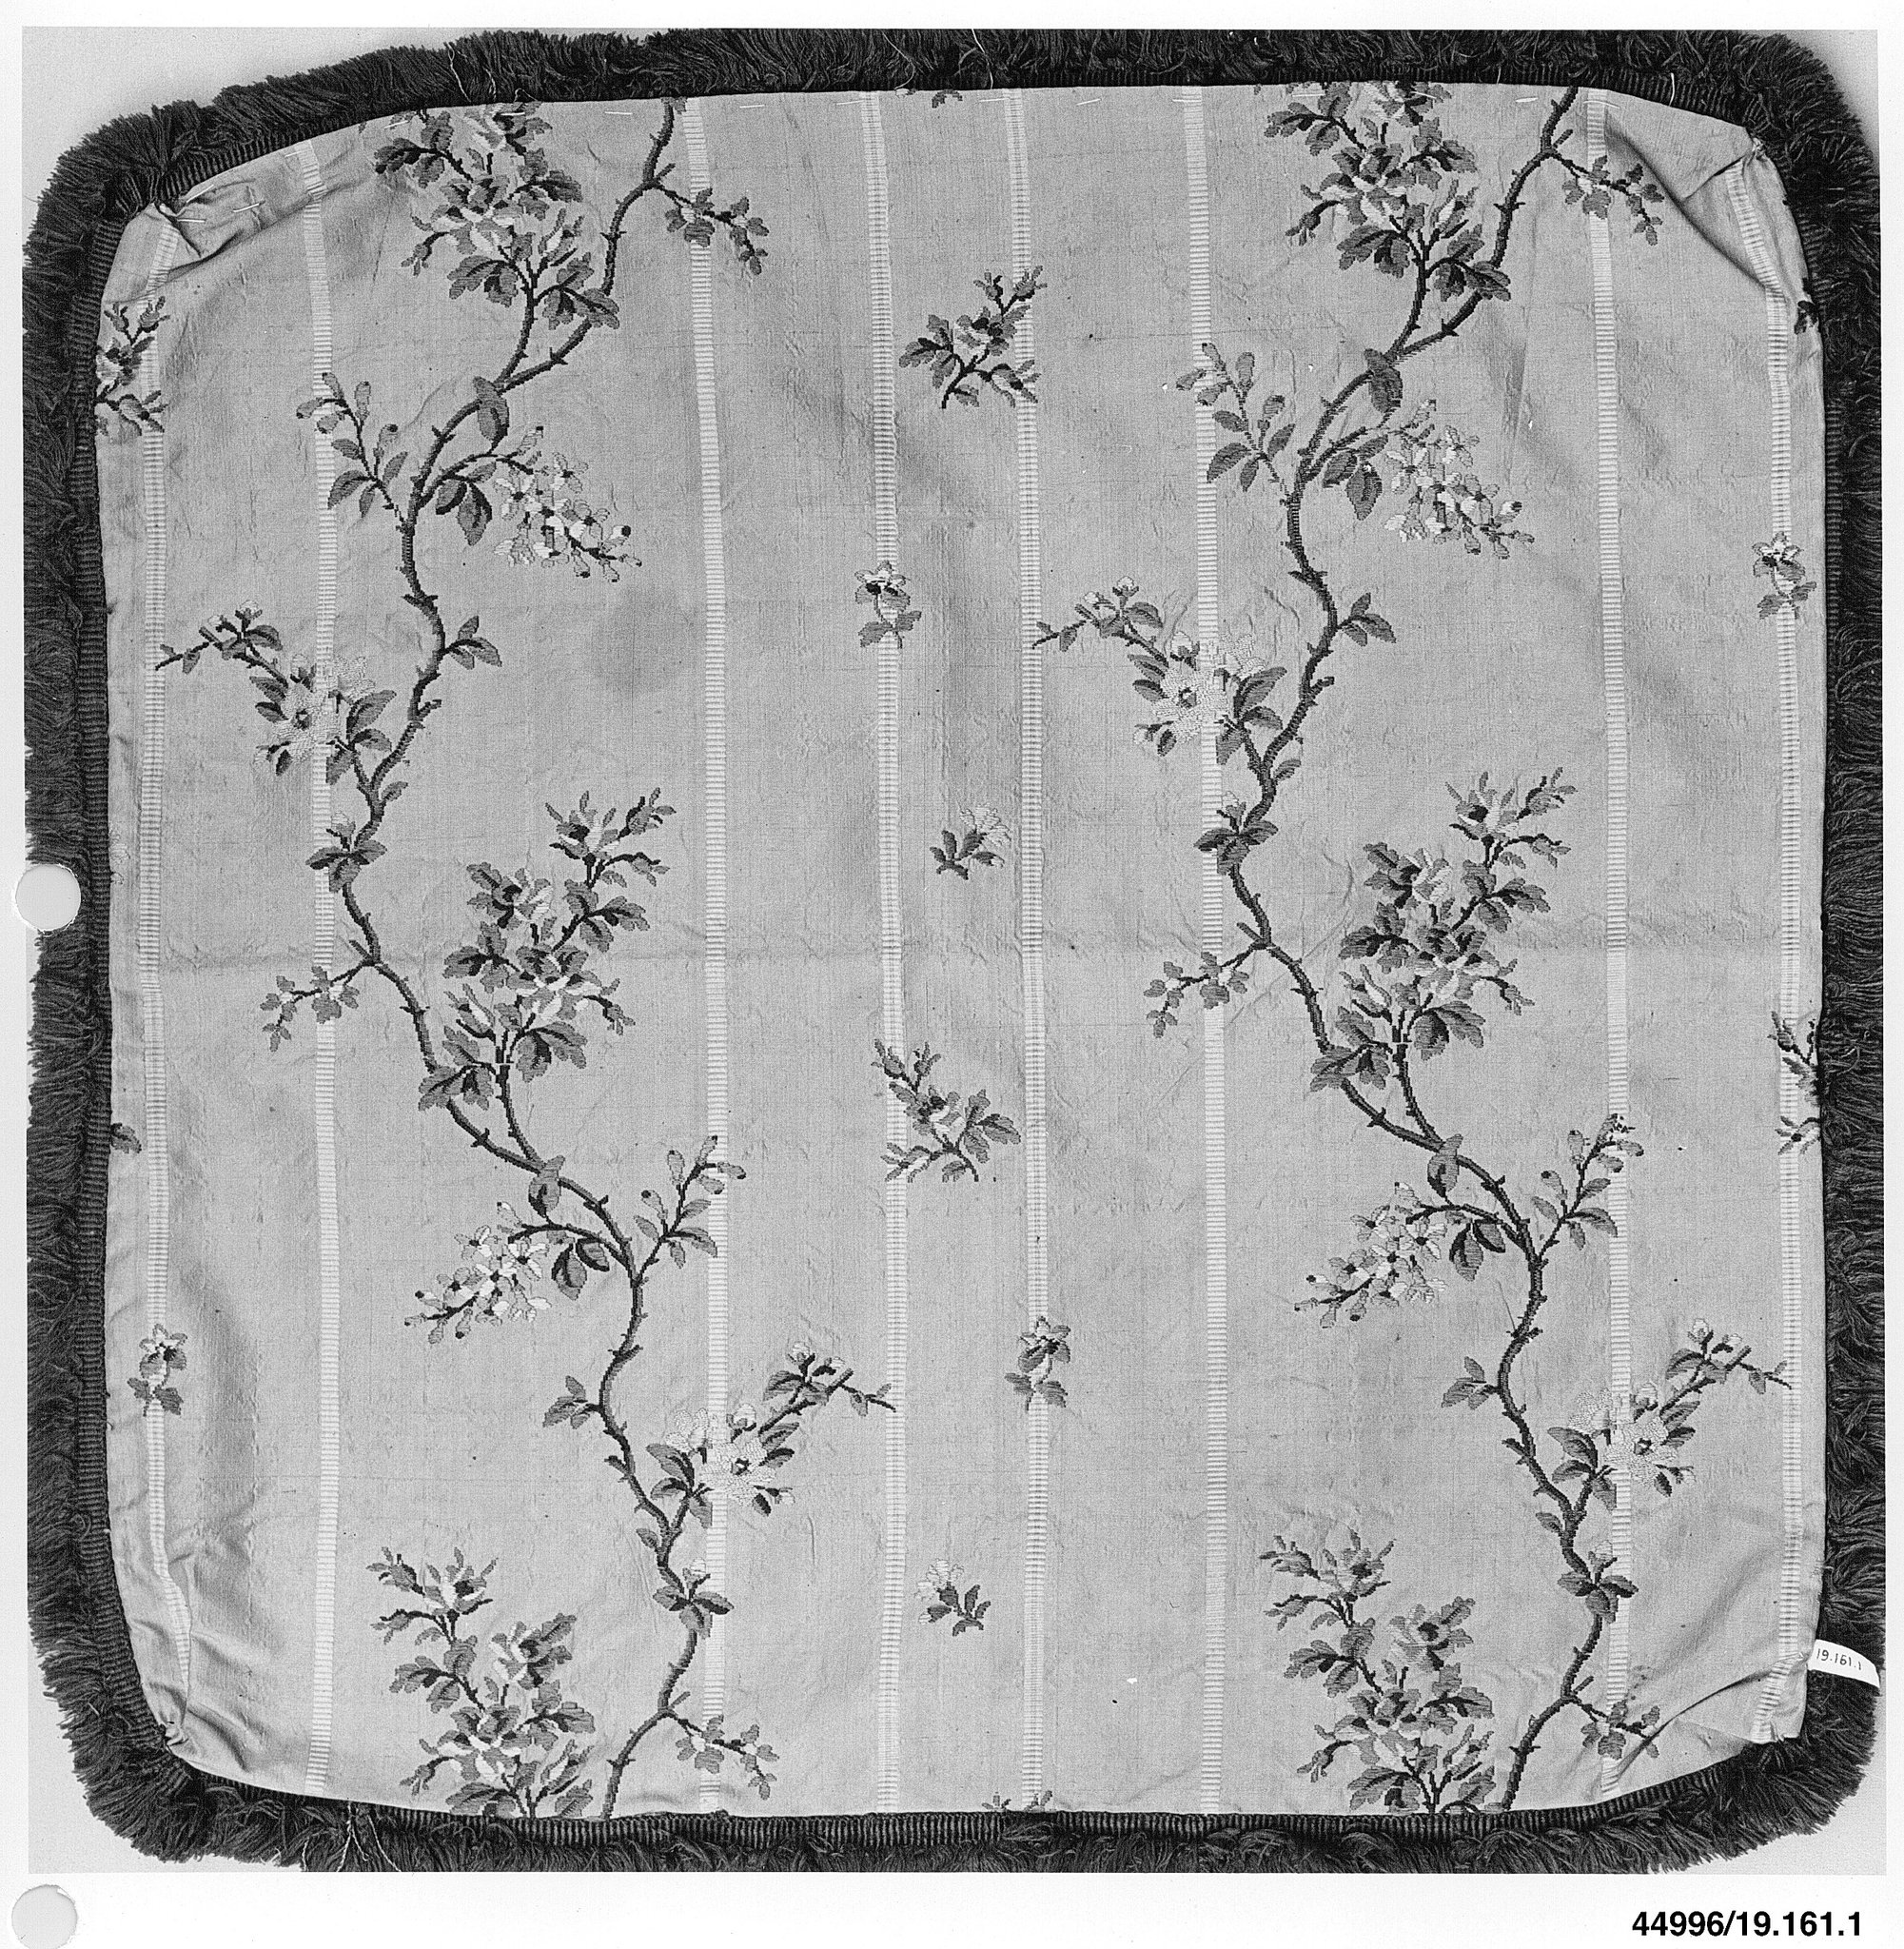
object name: piece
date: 1775-1790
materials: silk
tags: flowers,leaves